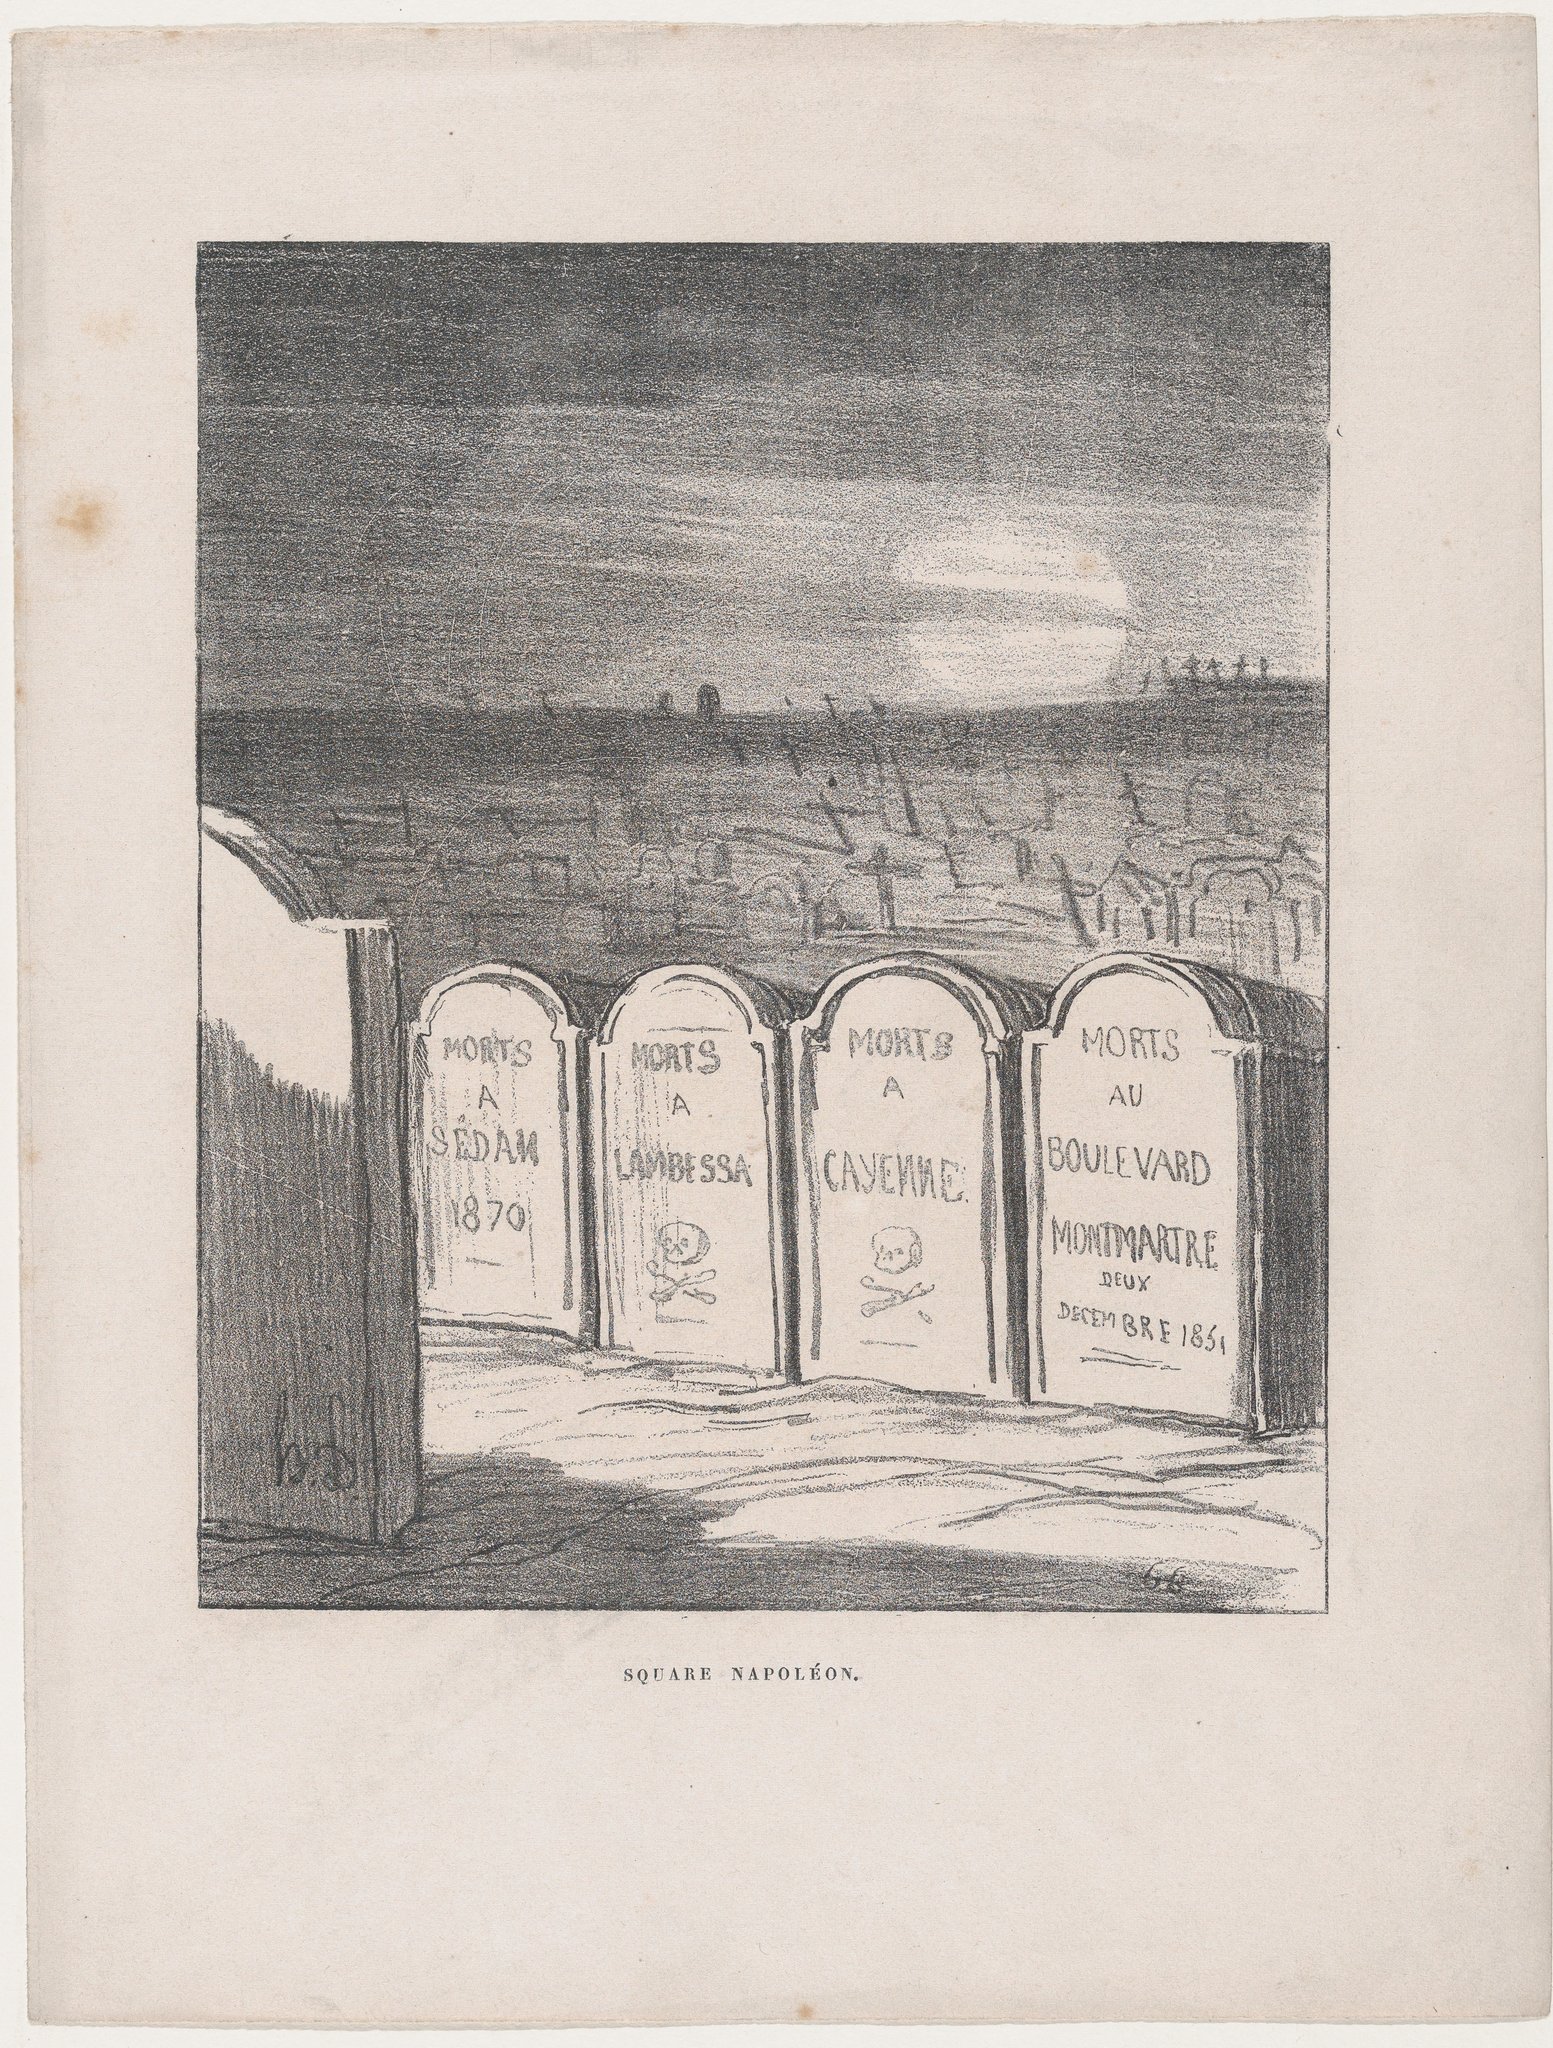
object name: print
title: Square Napoleon, from 'News of the day,' published in "L'Album du Siège"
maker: honoré daumier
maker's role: artist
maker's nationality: french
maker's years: 1808-1879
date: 1870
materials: paper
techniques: lithograph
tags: burial grounds